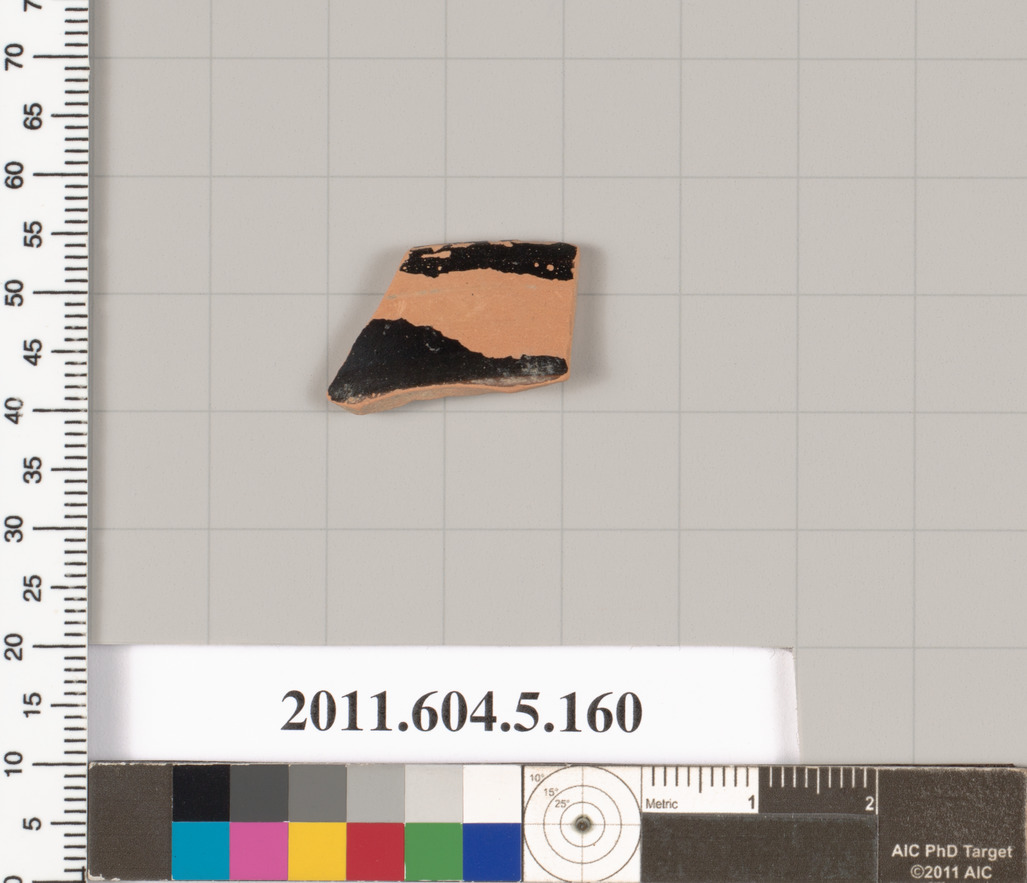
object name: kylix fragment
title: Terracotta rim fragment of a kylix (drinking cup)?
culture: greek, attic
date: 600-401 BCE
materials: terracotta